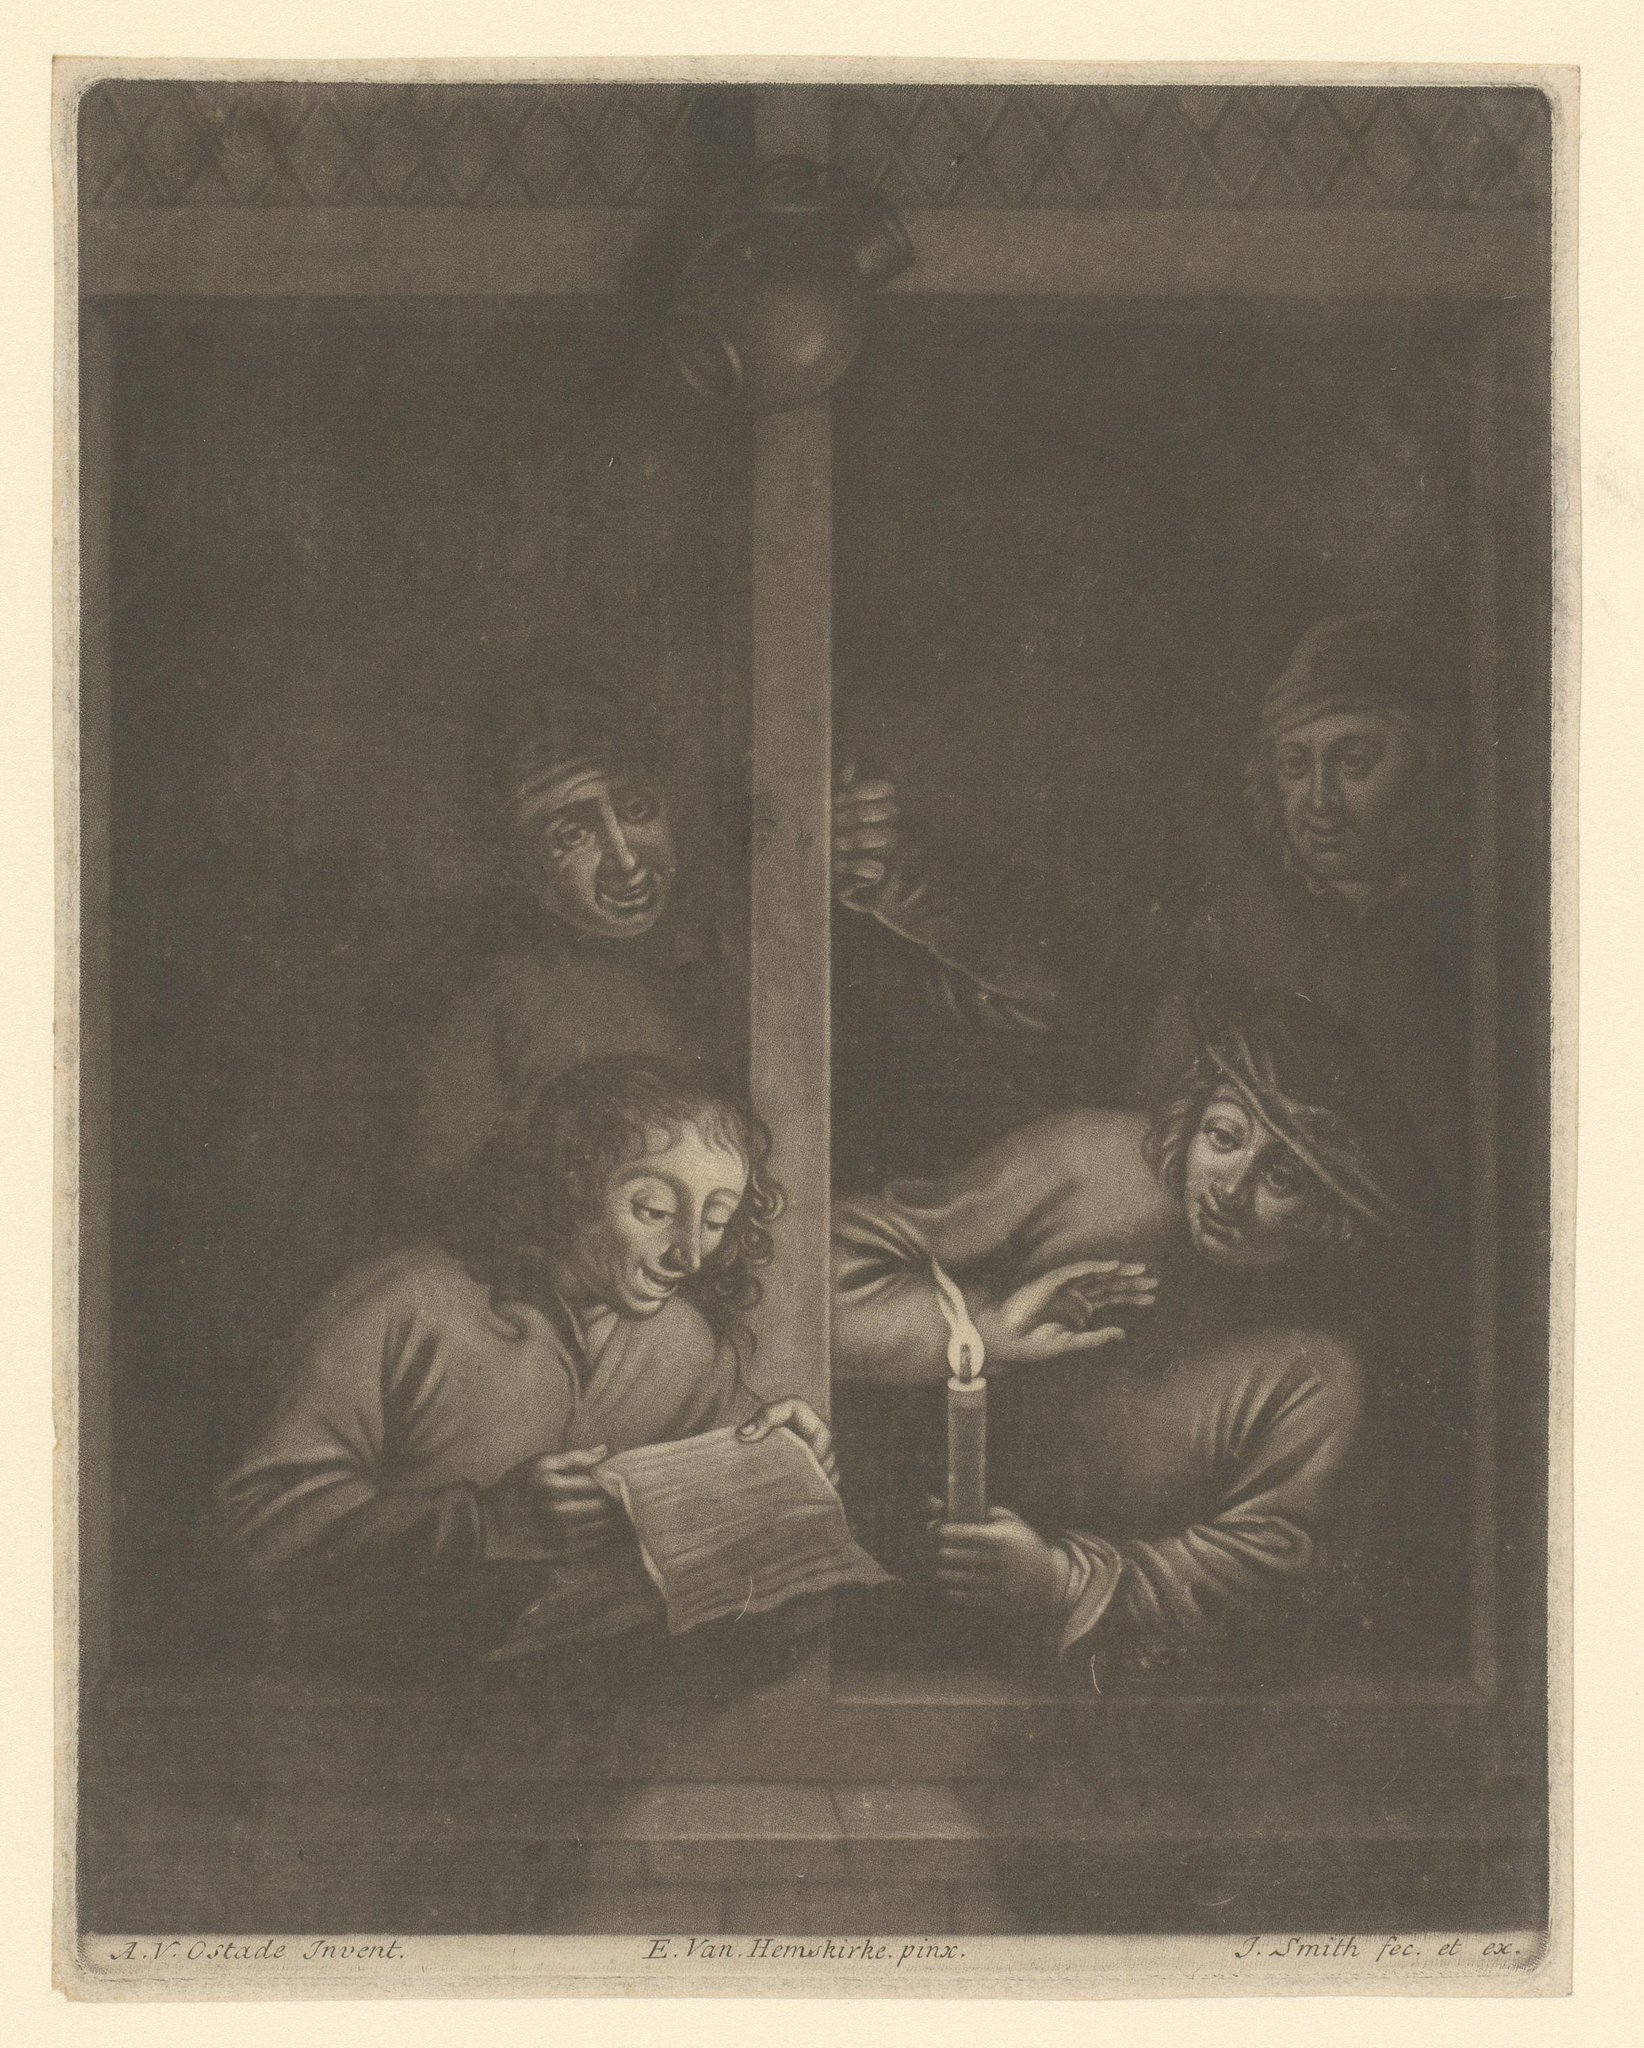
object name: print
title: Rederijkers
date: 1662-1742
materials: paper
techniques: mezzotint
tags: chamber of rhetoric (dutch: 'rederijkerskamer'), vocal music, singing, candle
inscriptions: collector's mark: Lugt 2228, collector's mark: Lugt 2760